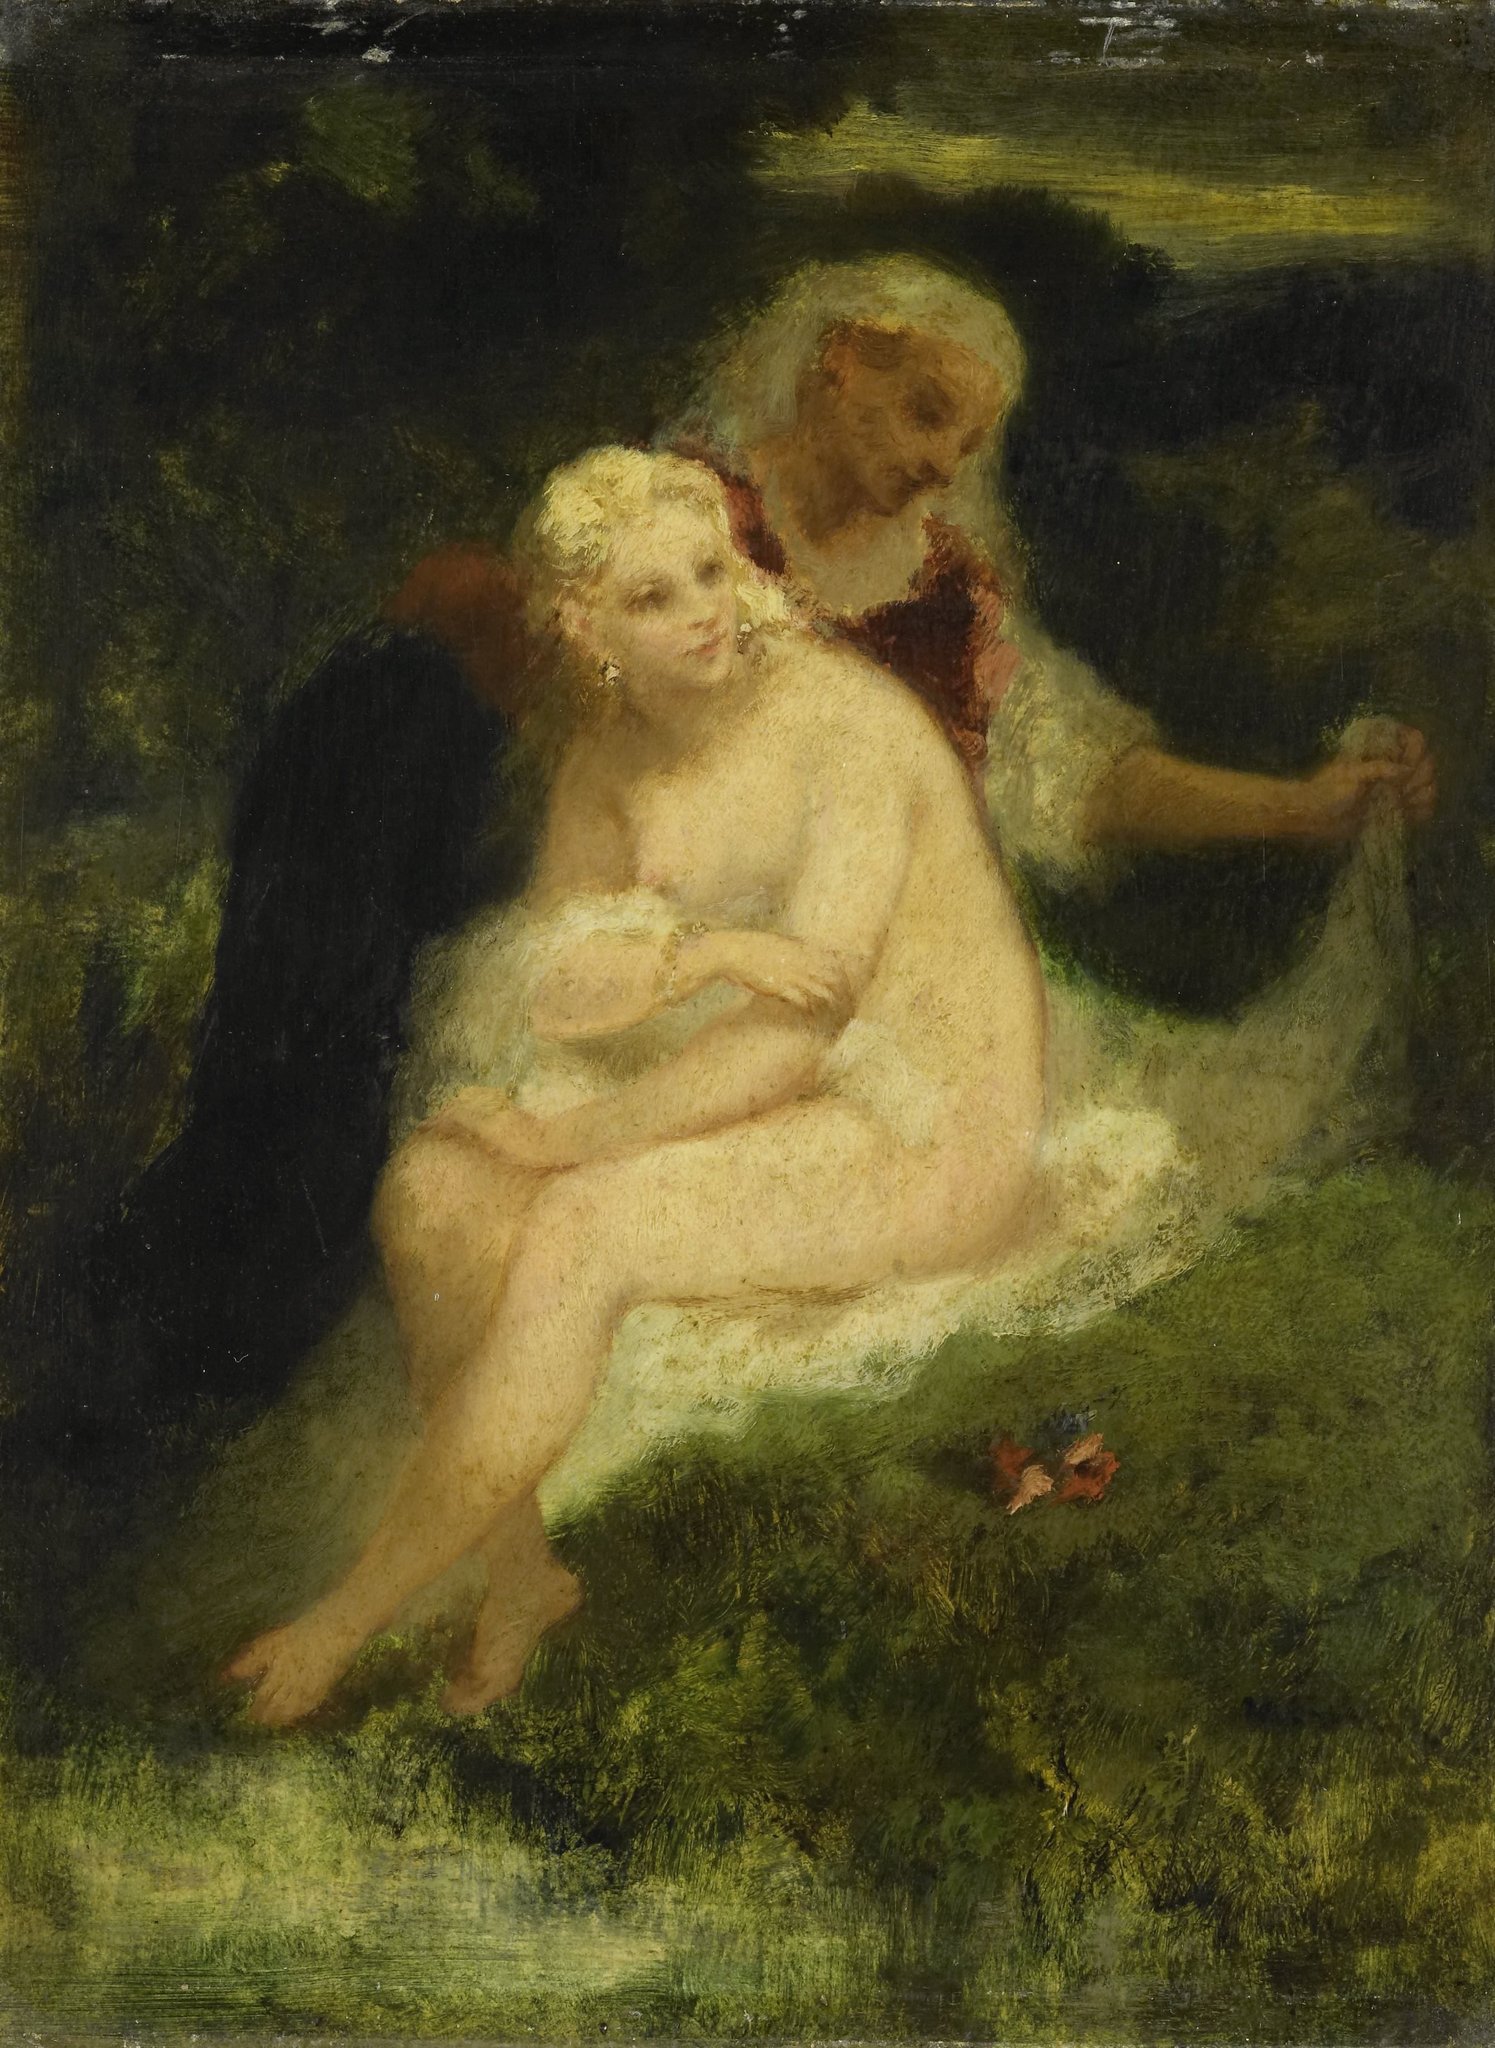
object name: painting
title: After the Bath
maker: narcisse virgile diaz de la peña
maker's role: draughtsman, painter, print maker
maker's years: 1808-1876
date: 1860-1876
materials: oil, panel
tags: 'après le bain' - aa - in the open air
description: Na het bad. Een naakte jonge vrouw zit op een doek aan de waterkant, achter haar een oude dienares.